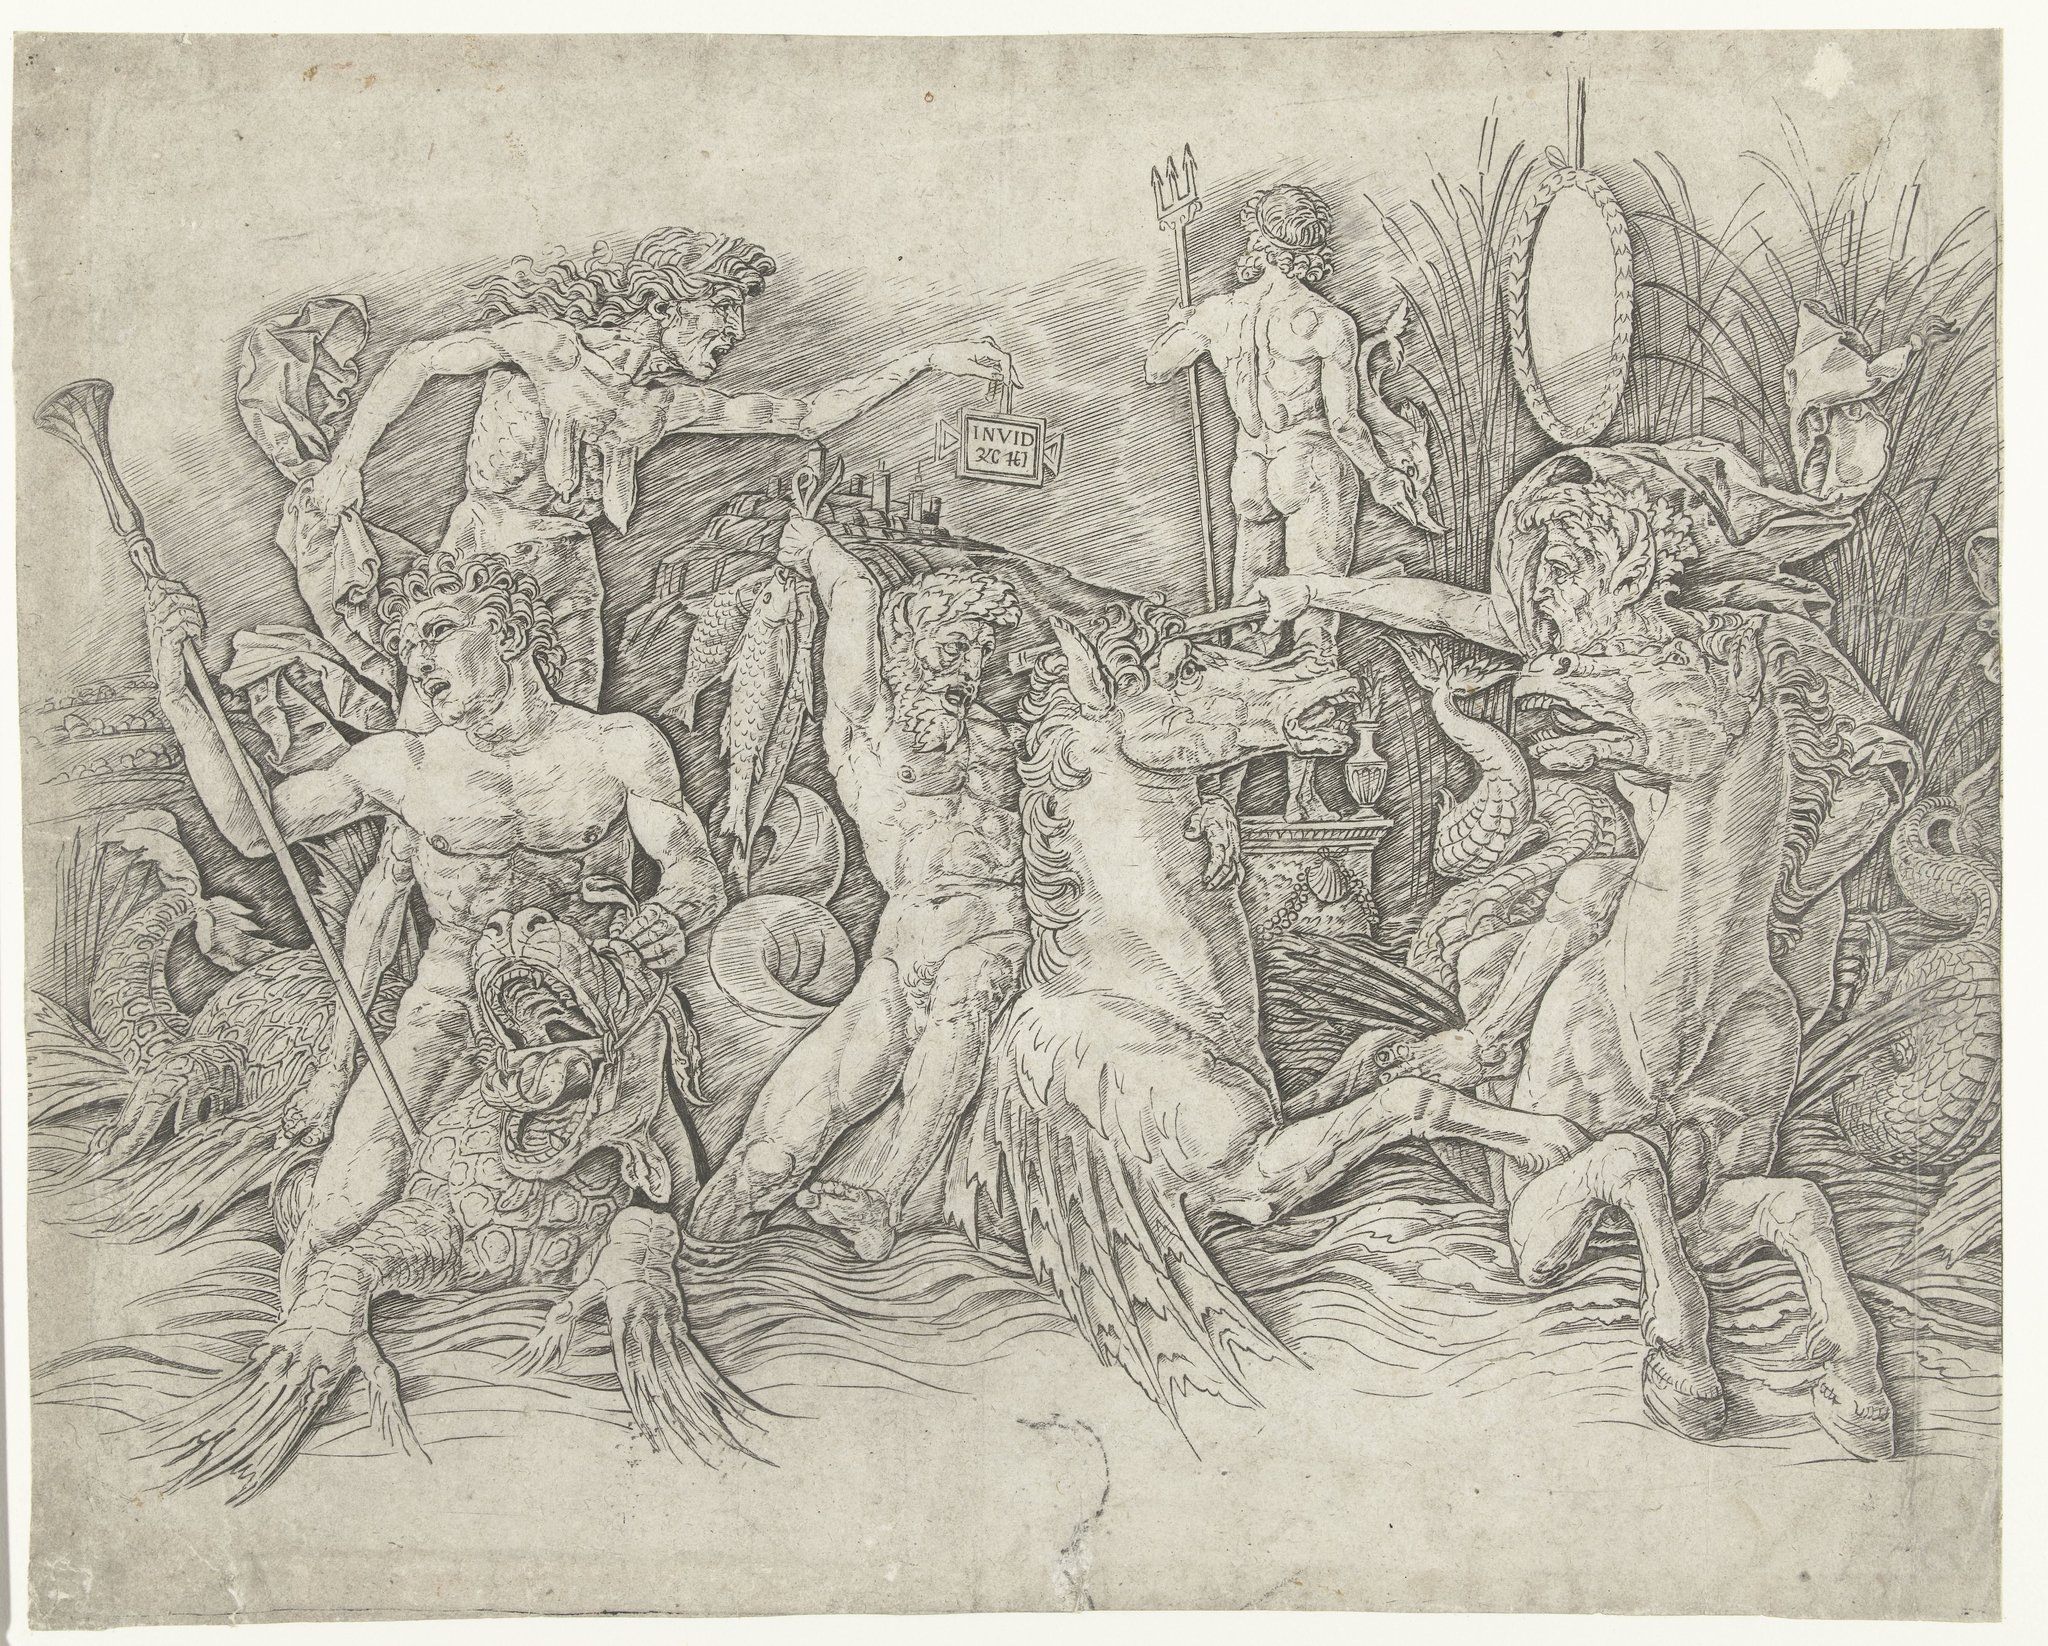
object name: print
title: Gevecht tussen satyrs rijdend op hippocampussen en oude vrouw als personificatie van afgunst staand op rug van draak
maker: andrea mantegna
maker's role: print maker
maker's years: 1431-1506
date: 1473-1477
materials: paper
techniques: engraving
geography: italy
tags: dragon (large fabulous serpent, sometimes with wings and legs), envy; 'invidia' (ripa) ~ personification of one of the seven deadly sins, bony fishes: hippocampus - ff - fabulous animals (sometimes wrongly called 'grotesques'); 'mostri' (ripa)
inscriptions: collector's mark: Lugt 240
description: Gevecht tussen satyrs rijdend op hippocampussen en oude vrouw als personificatie van afgunst staand op rug van draak. De vrouw houdt een bordje vast met de tekst INVID (Afgunst). Op een sokkel staat Neptunus met een dolfijn en drietand.